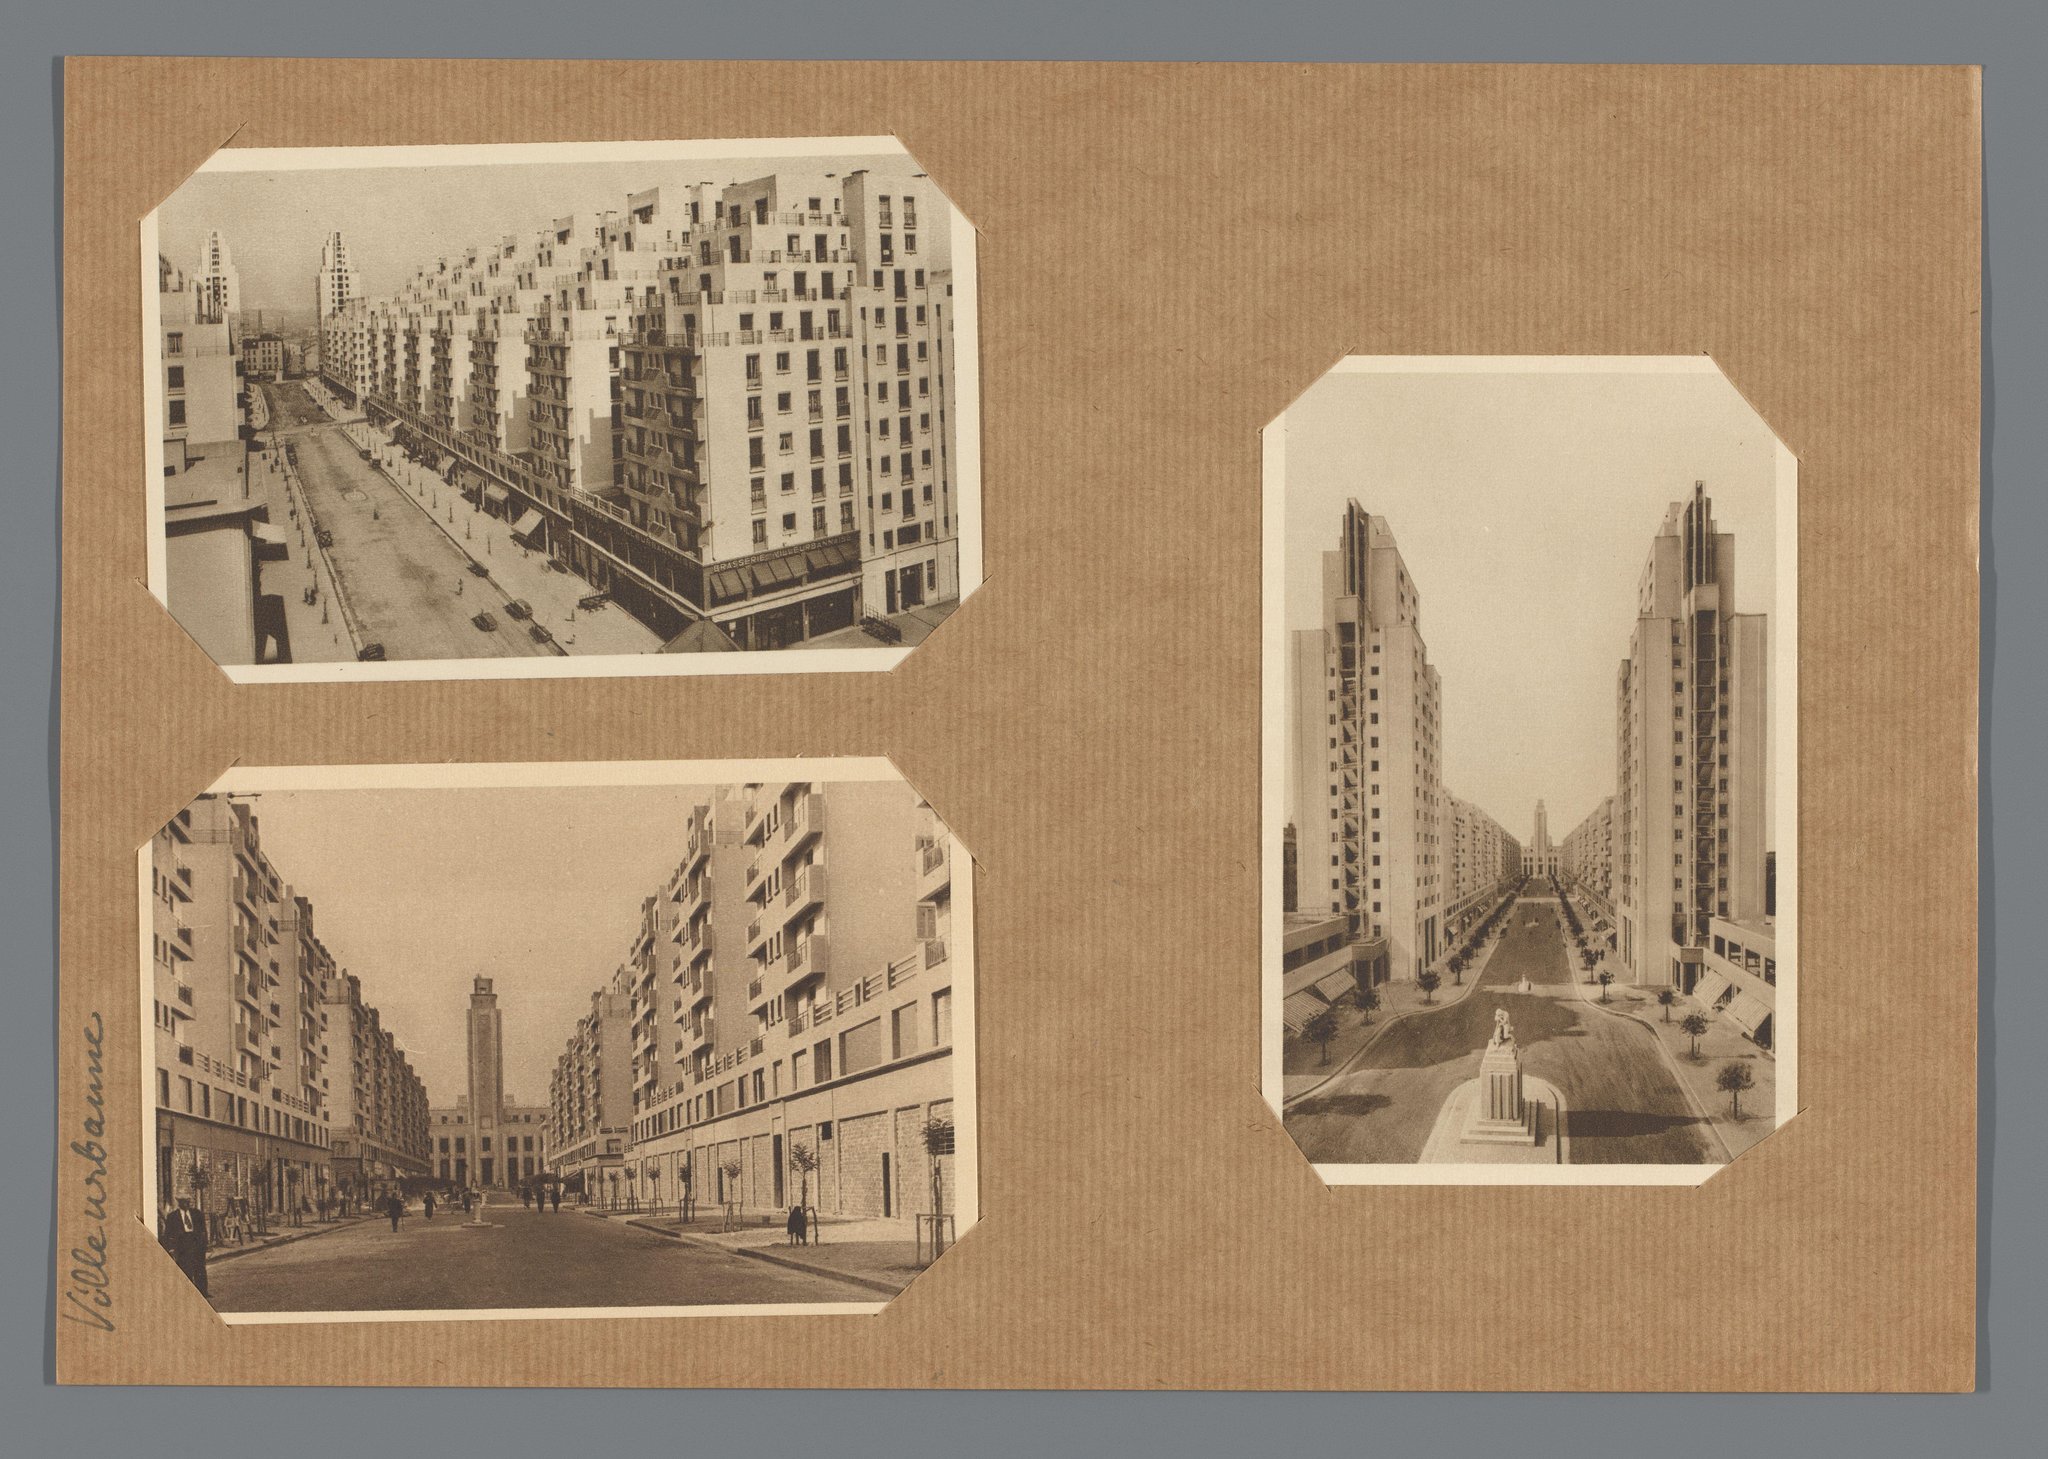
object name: photograph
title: Villeurbanne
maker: Anonymous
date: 1900-1950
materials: paper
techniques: rotogravure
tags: villeurbanne